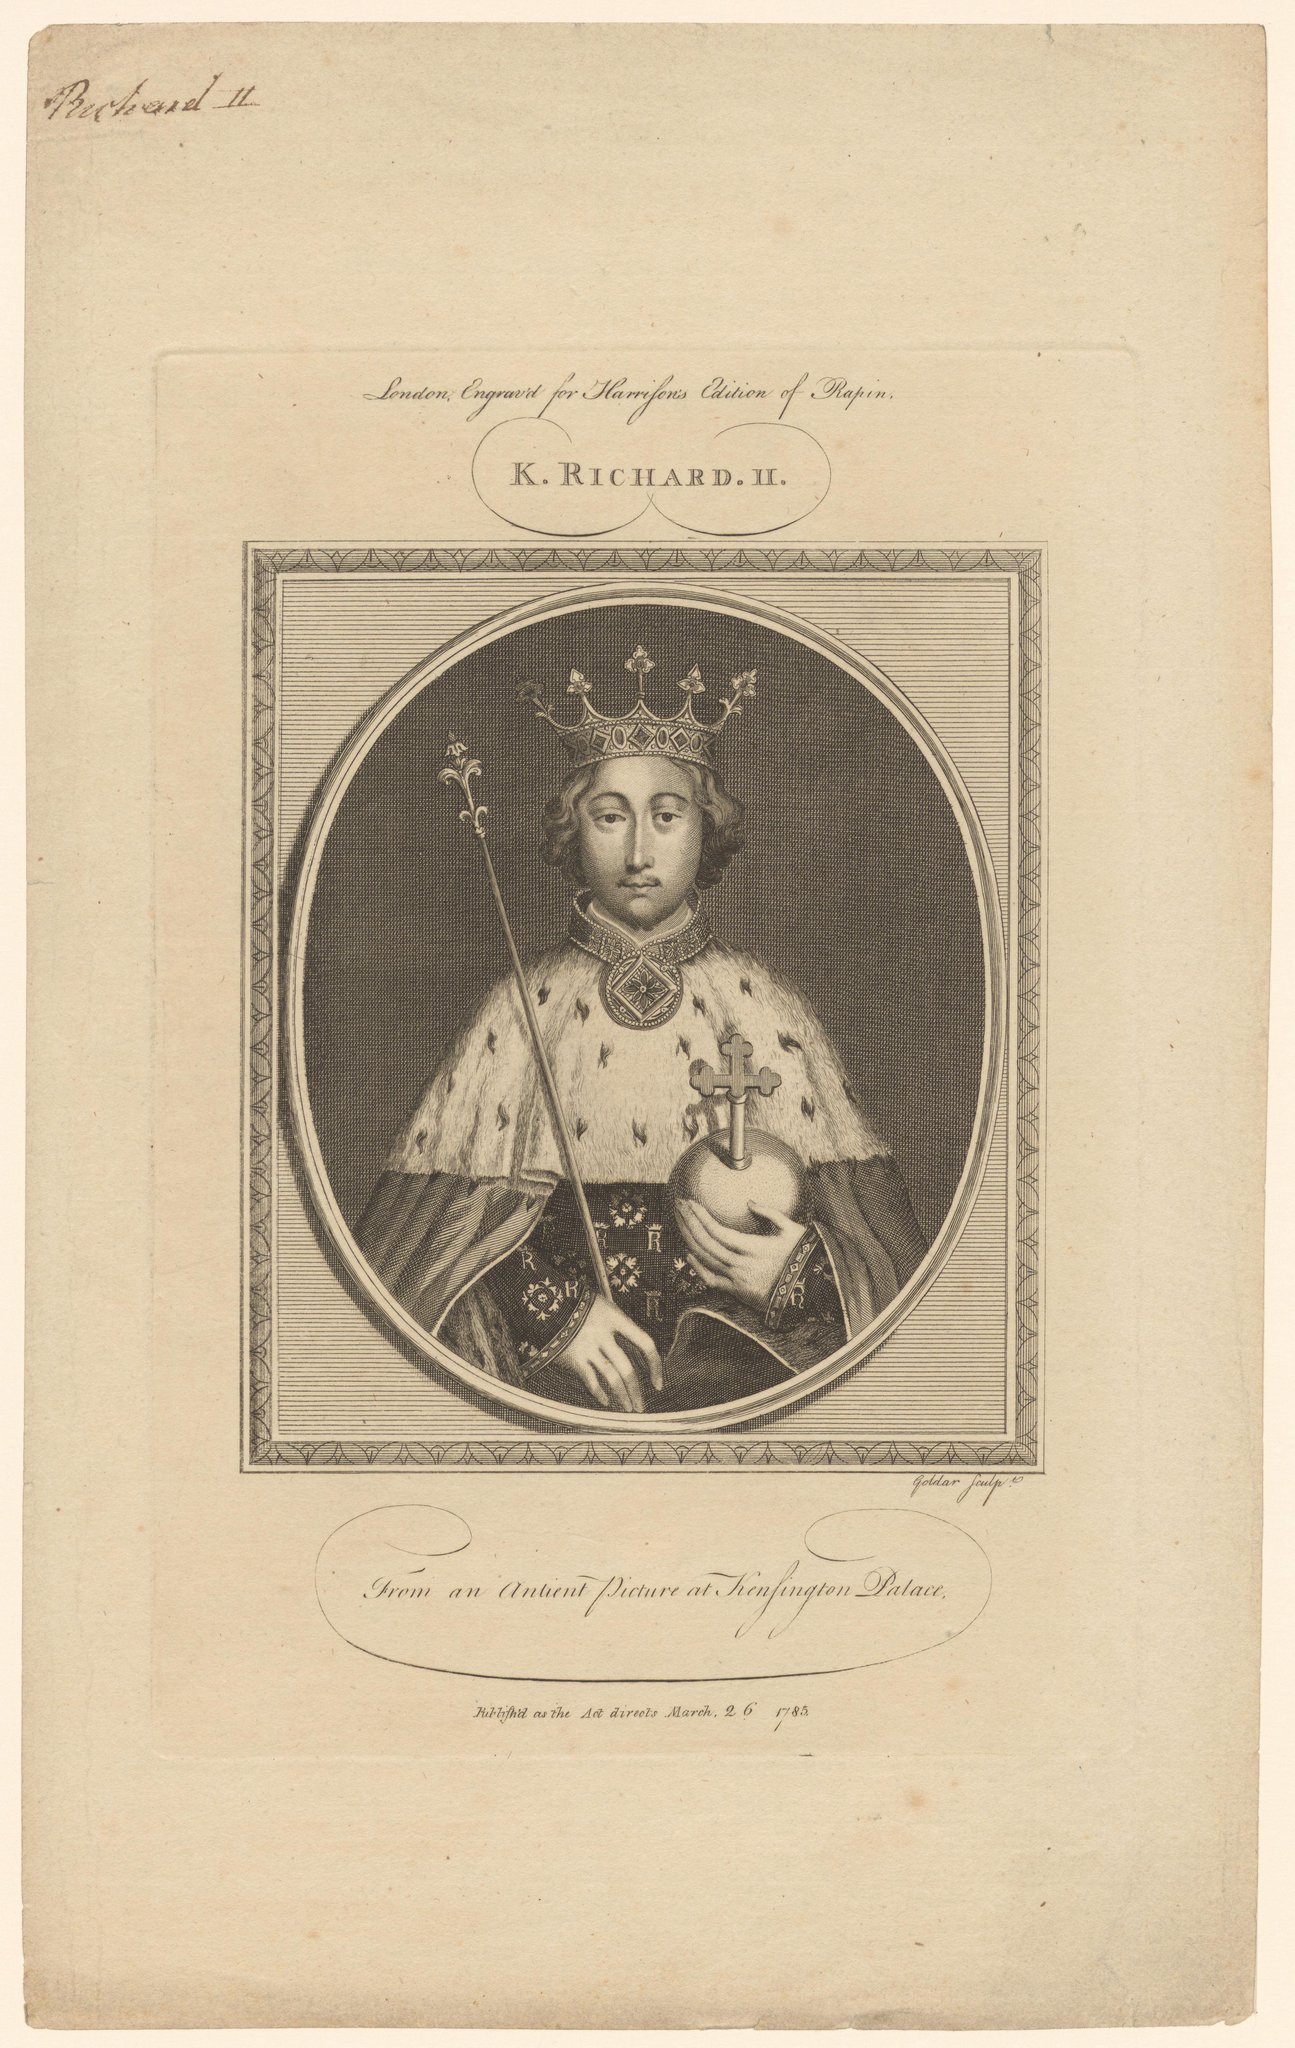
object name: print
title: Portret van Richard II, koning van Engeland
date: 1785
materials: paper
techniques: engraving, etching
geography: london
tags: historical persons, king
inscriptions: collector's mark: Lugt 2228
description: Prent is gebruikt in: Rapin, Paul de. History of England. [Vertaald uit het Frans door] Nicolas Tindal. Londen: John Harrison, 1785. Het schilderij waar deze prent op is gebaseerd bevindt zich in de collectie van Westminster Abbey.